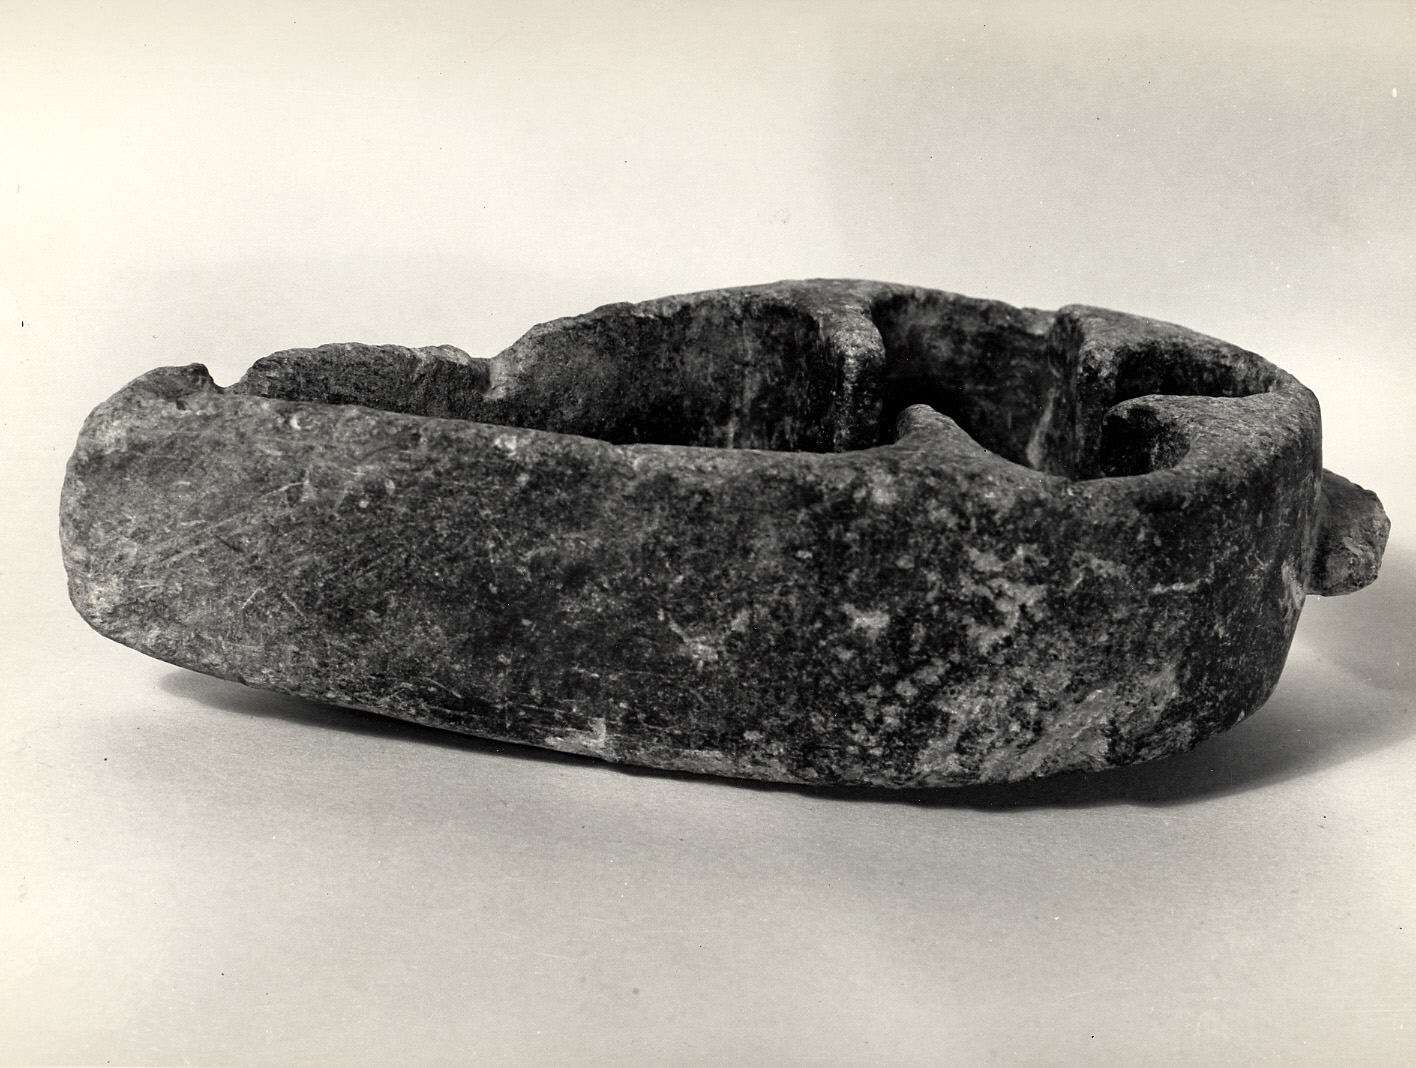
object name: lamp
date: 801-1000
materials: stone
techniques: carving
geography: iran